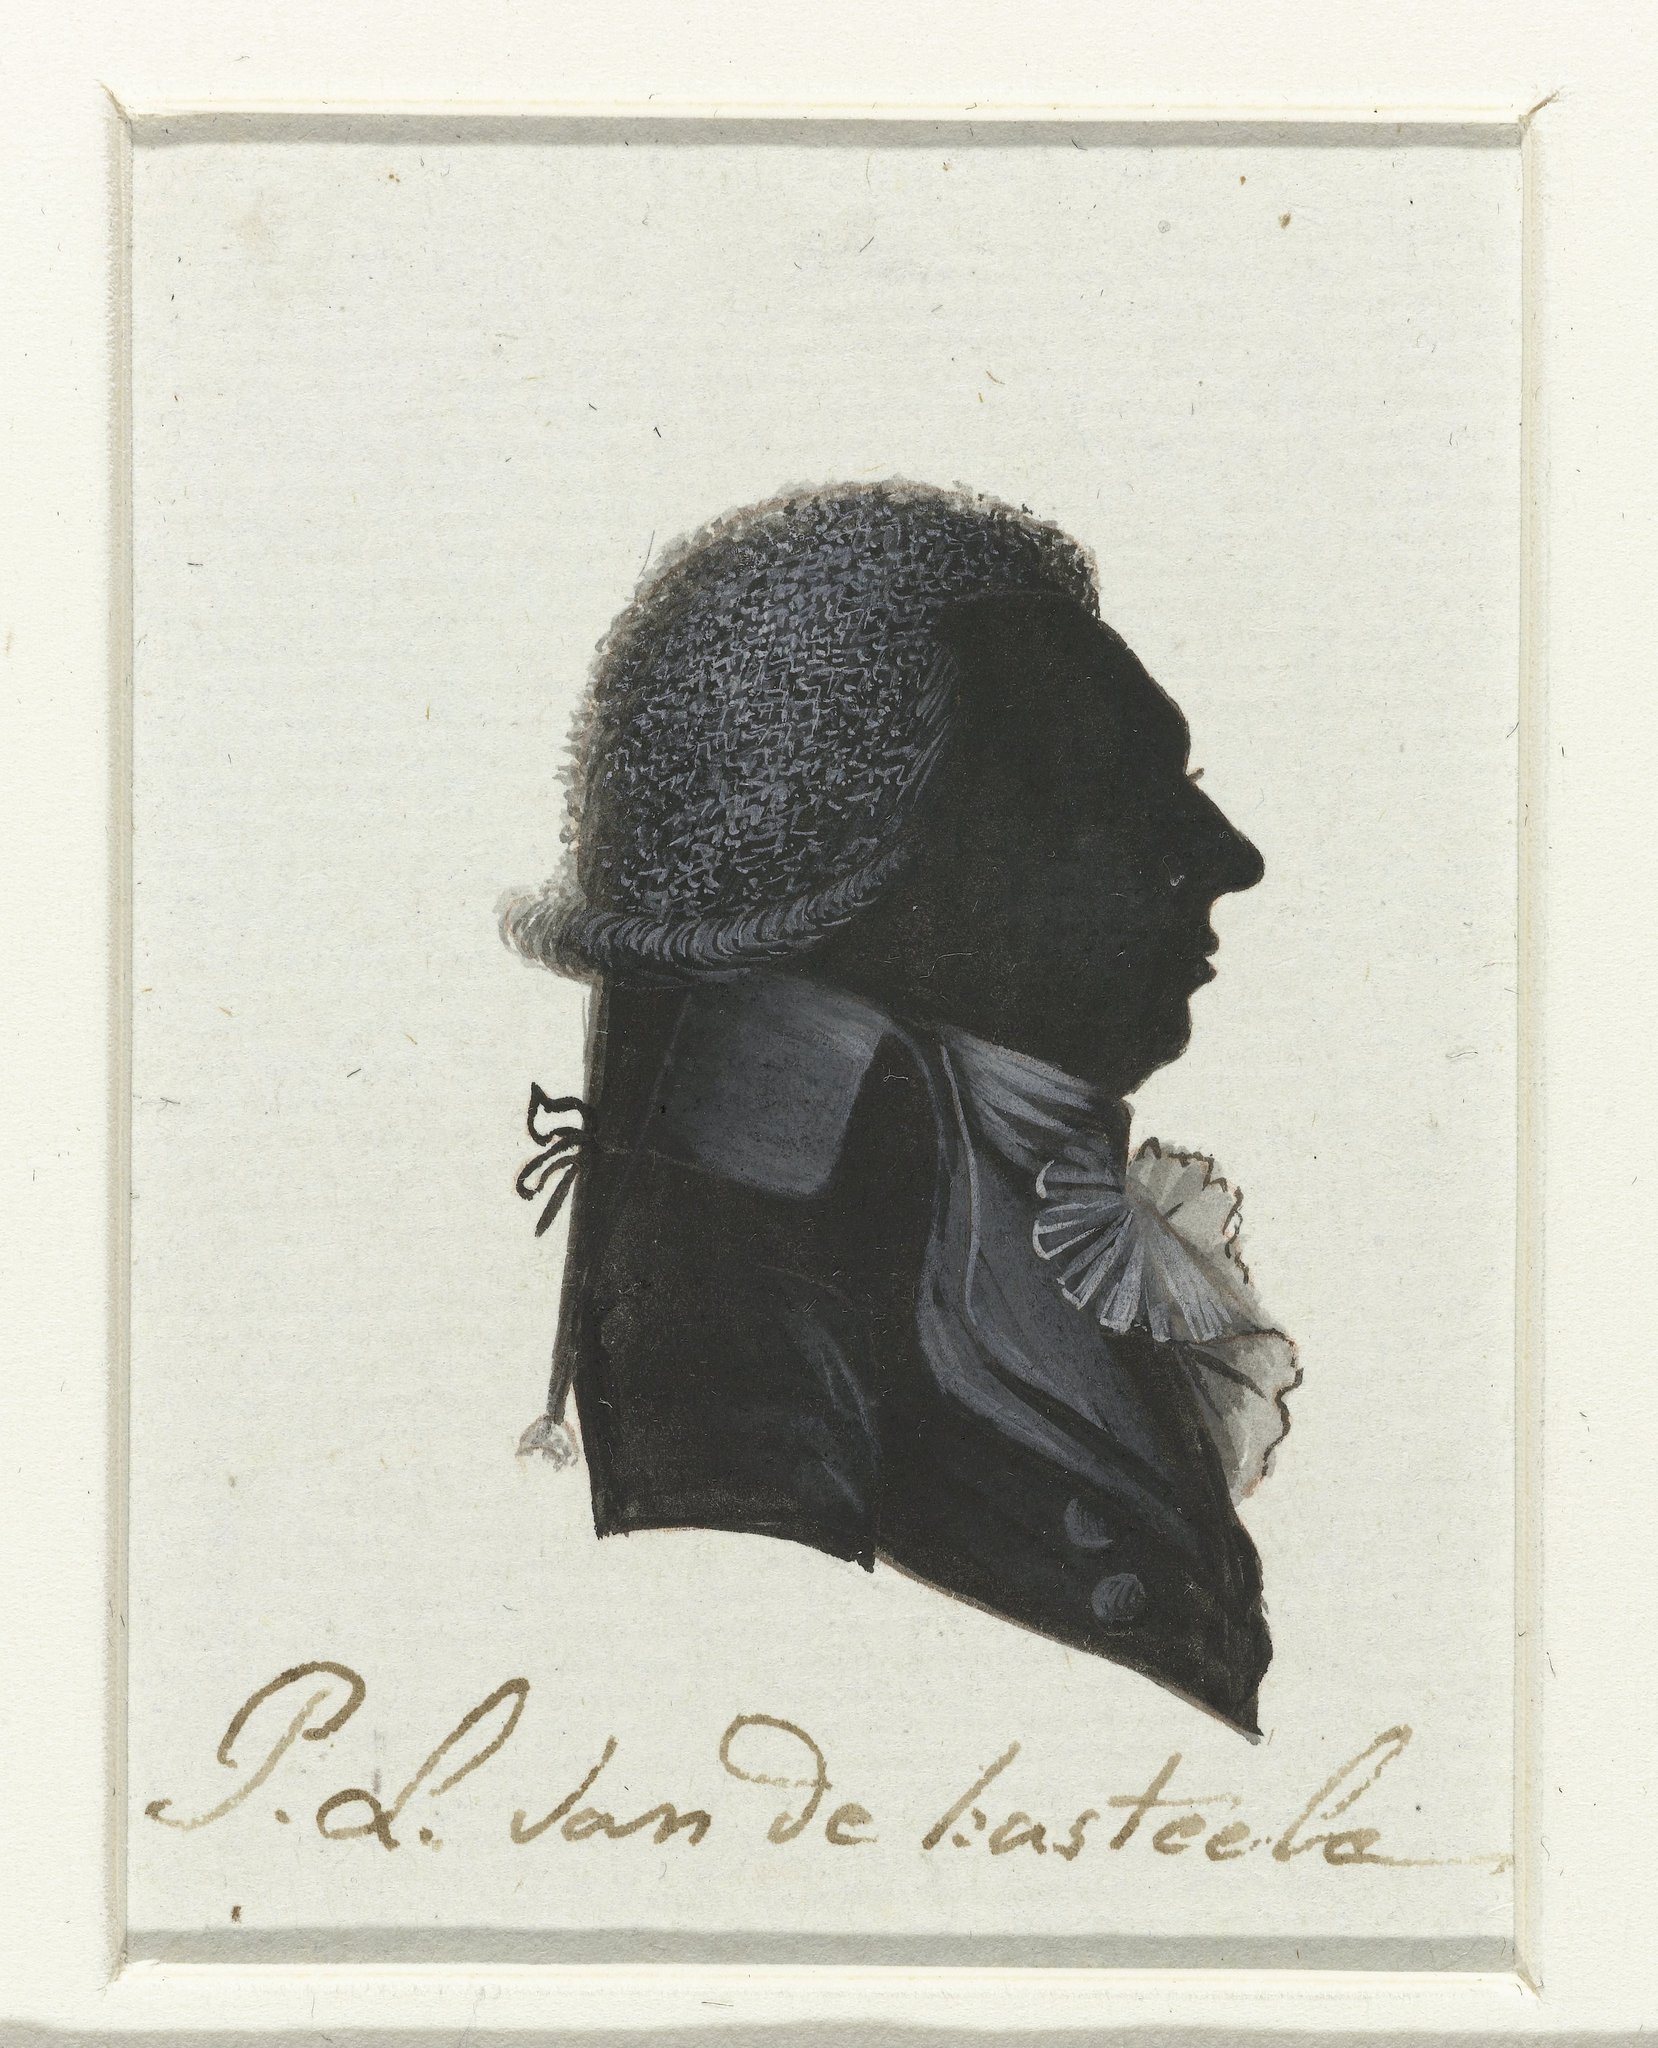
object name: silhouette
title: Representanten van de eerste Nationale Vergadering van de Bataafse Republiek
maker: hausdorff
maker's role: draughtsman, print maker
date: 1796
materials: ink, paper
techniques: drawing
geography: netherlands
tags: the hague, pieter leonard van de kasteele, historical persons (+ profile portrait), leiden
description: Silhouettes of members of the National Assembly. India ink on paper, 1796. Early in 1795 Stadholder William V fled to England. In the Republic a new regime was installed. A year later, the country held its first general election. Every Dutch man over the age of twenty and not on poor relief was entitled to vote for a candidate to the National Assembly, the parliament of the Batavian Republic, as the country was known between 1795 and 1806. The 126 representatives who sat in the assembly were drawn from the educated, progressive elite of Dutch society.